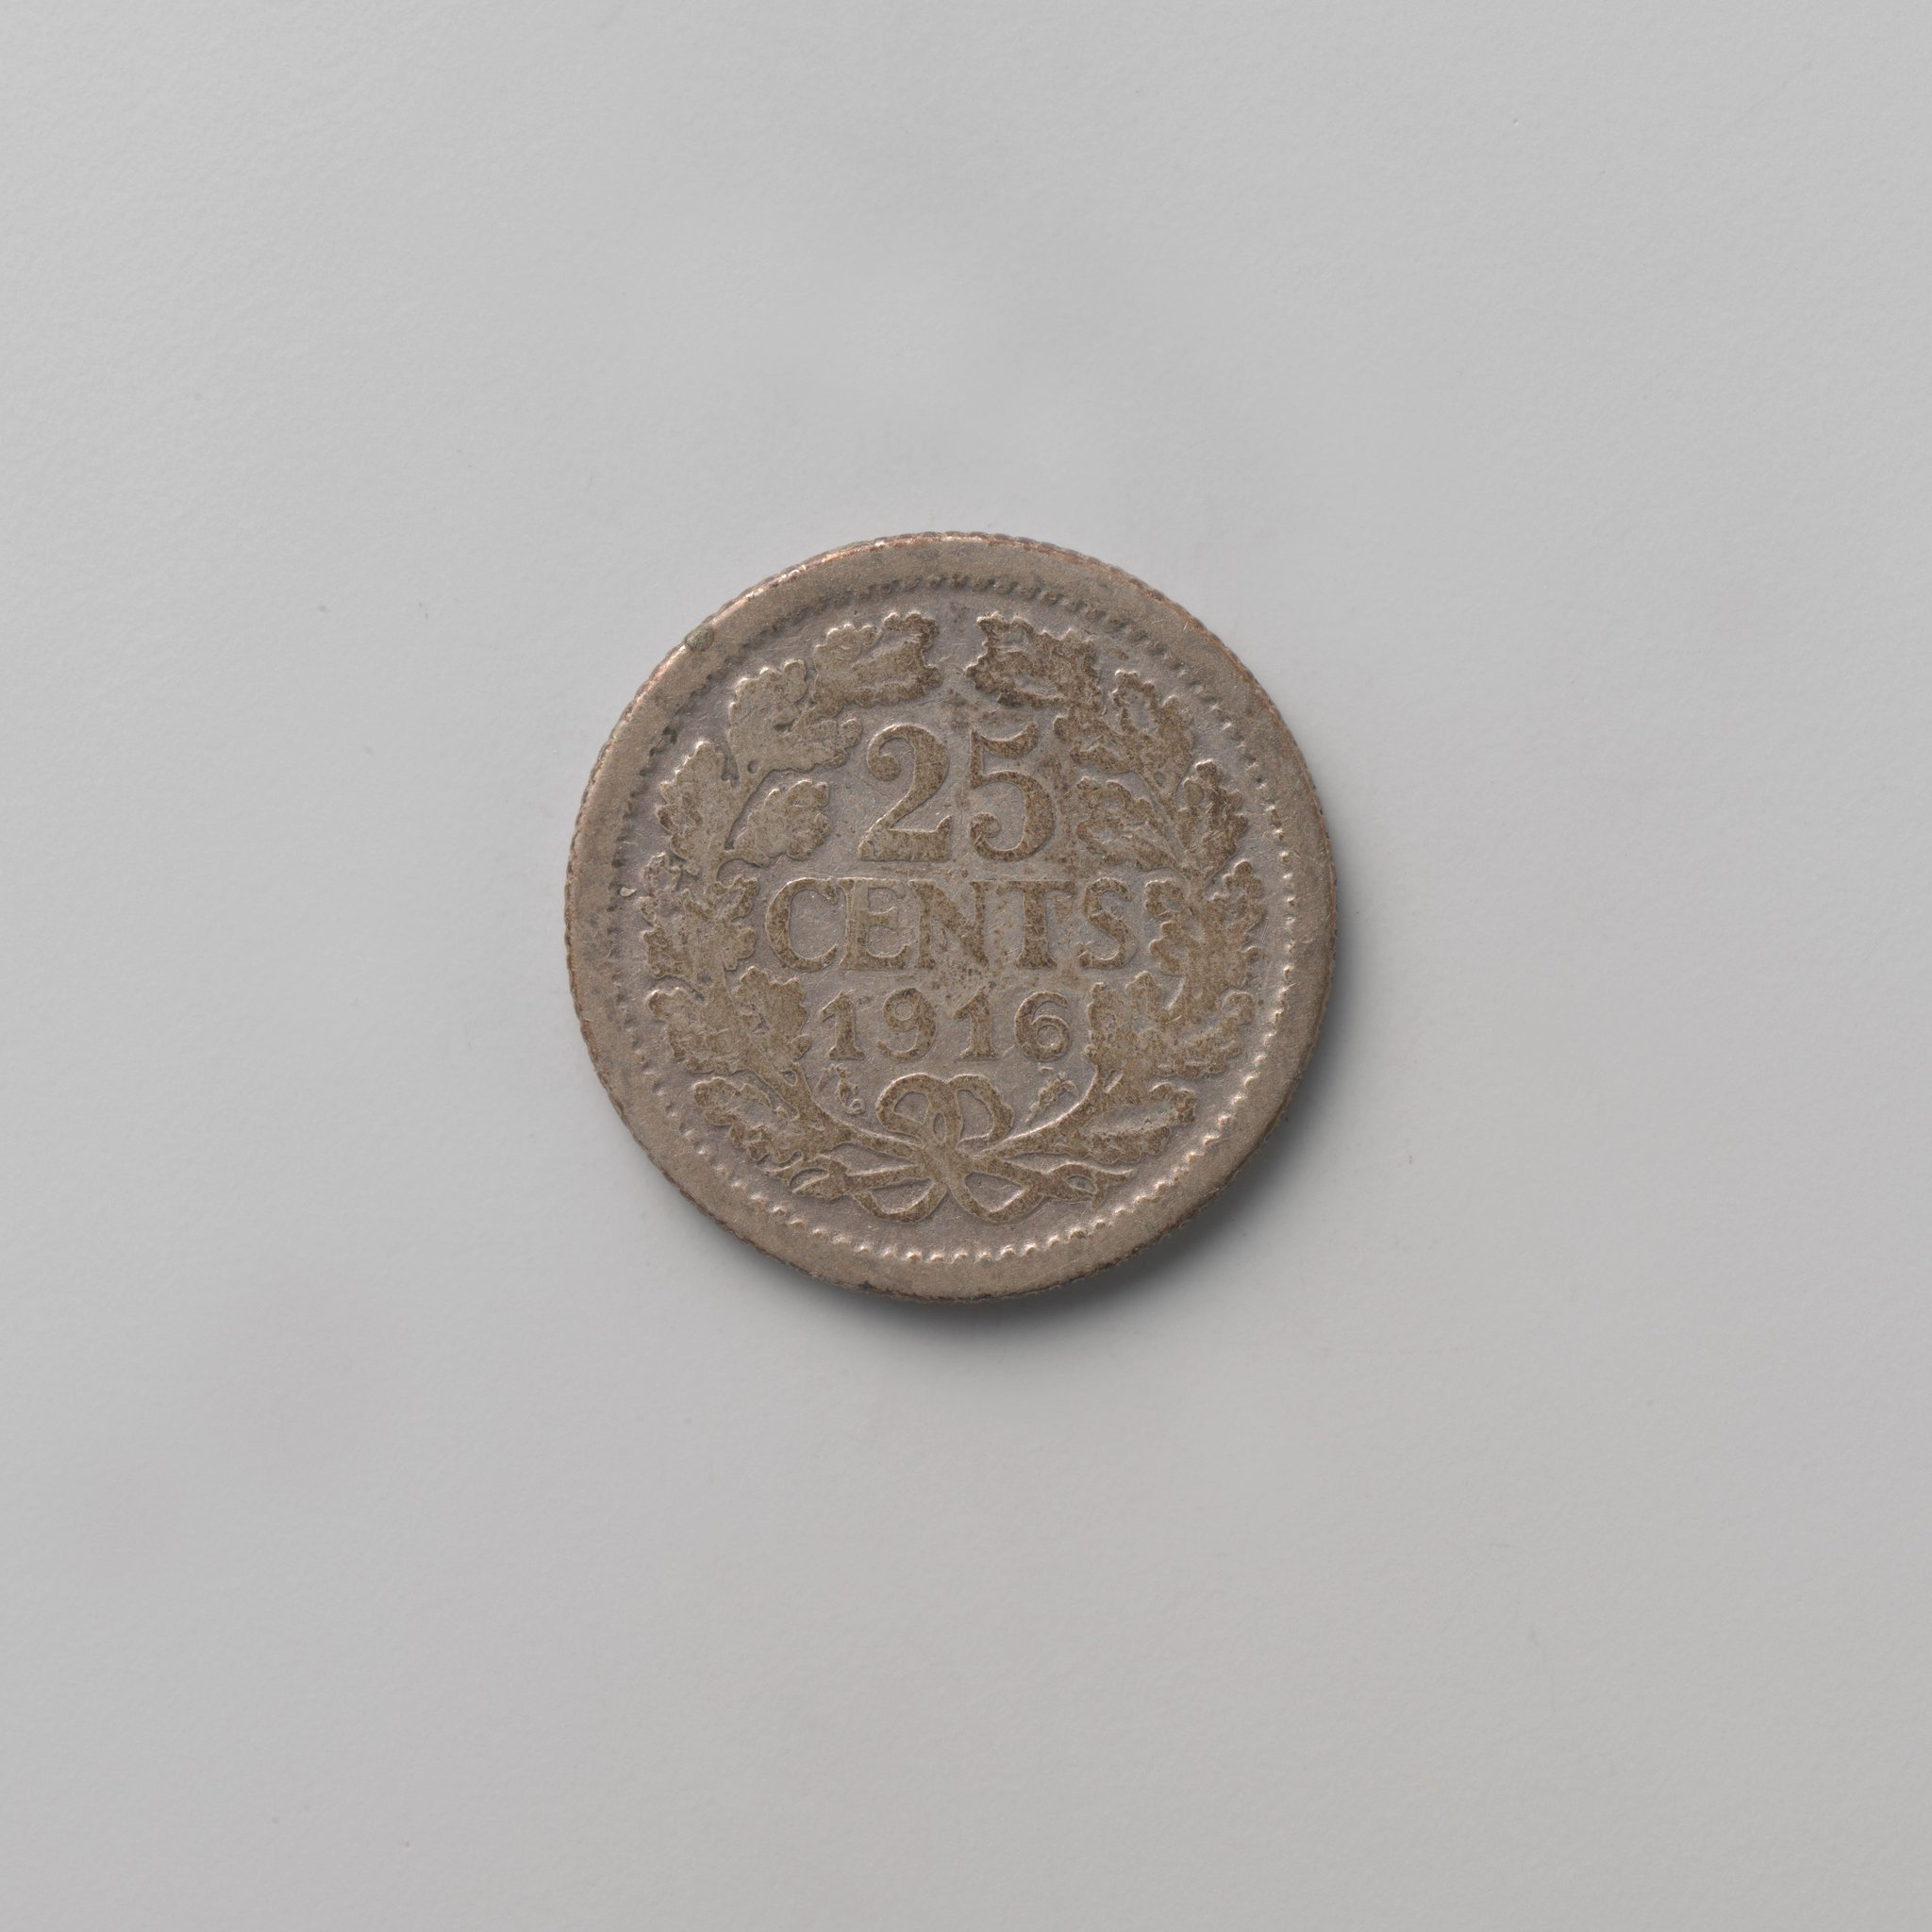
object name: coin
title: Nederland, 25 cent,1916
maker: wilhelmina of the netherlands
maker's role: print maker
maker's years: 1880-1962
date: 1916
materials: silver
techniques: striking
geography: utrecht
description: Zilveren munt. Voorzijde: gedrapeerd borstbeeld naar links. Keerzijde: binnen twee samengebonden eiketakken waarde-aanduiding 25 cents en jaartal. Kartelrand.